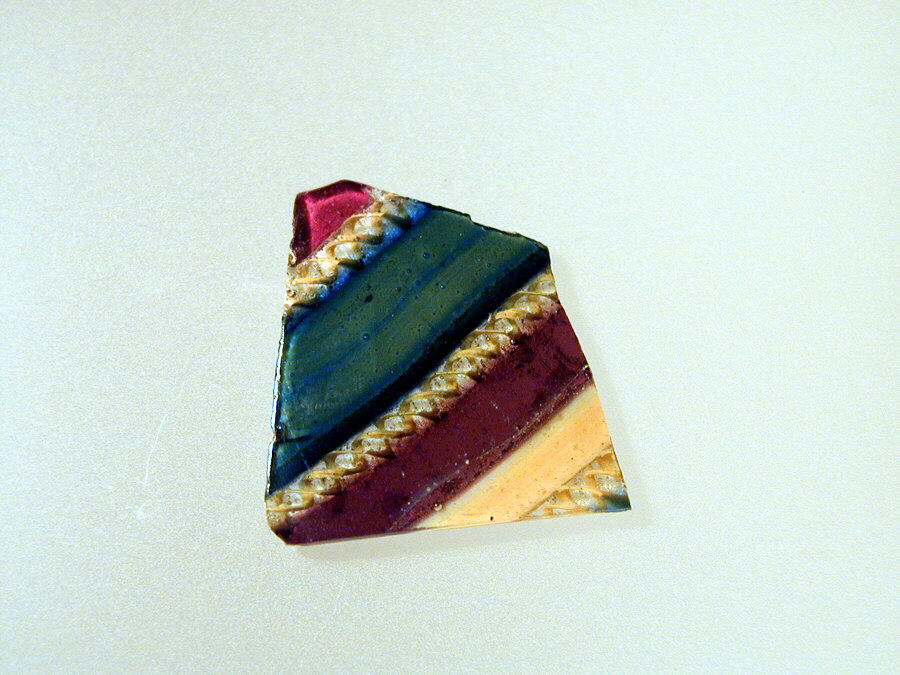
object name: fragment, striped mosaic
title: Glass striped mosaic bowl fragment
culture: roman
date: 34 BCE-33 CE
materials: glass